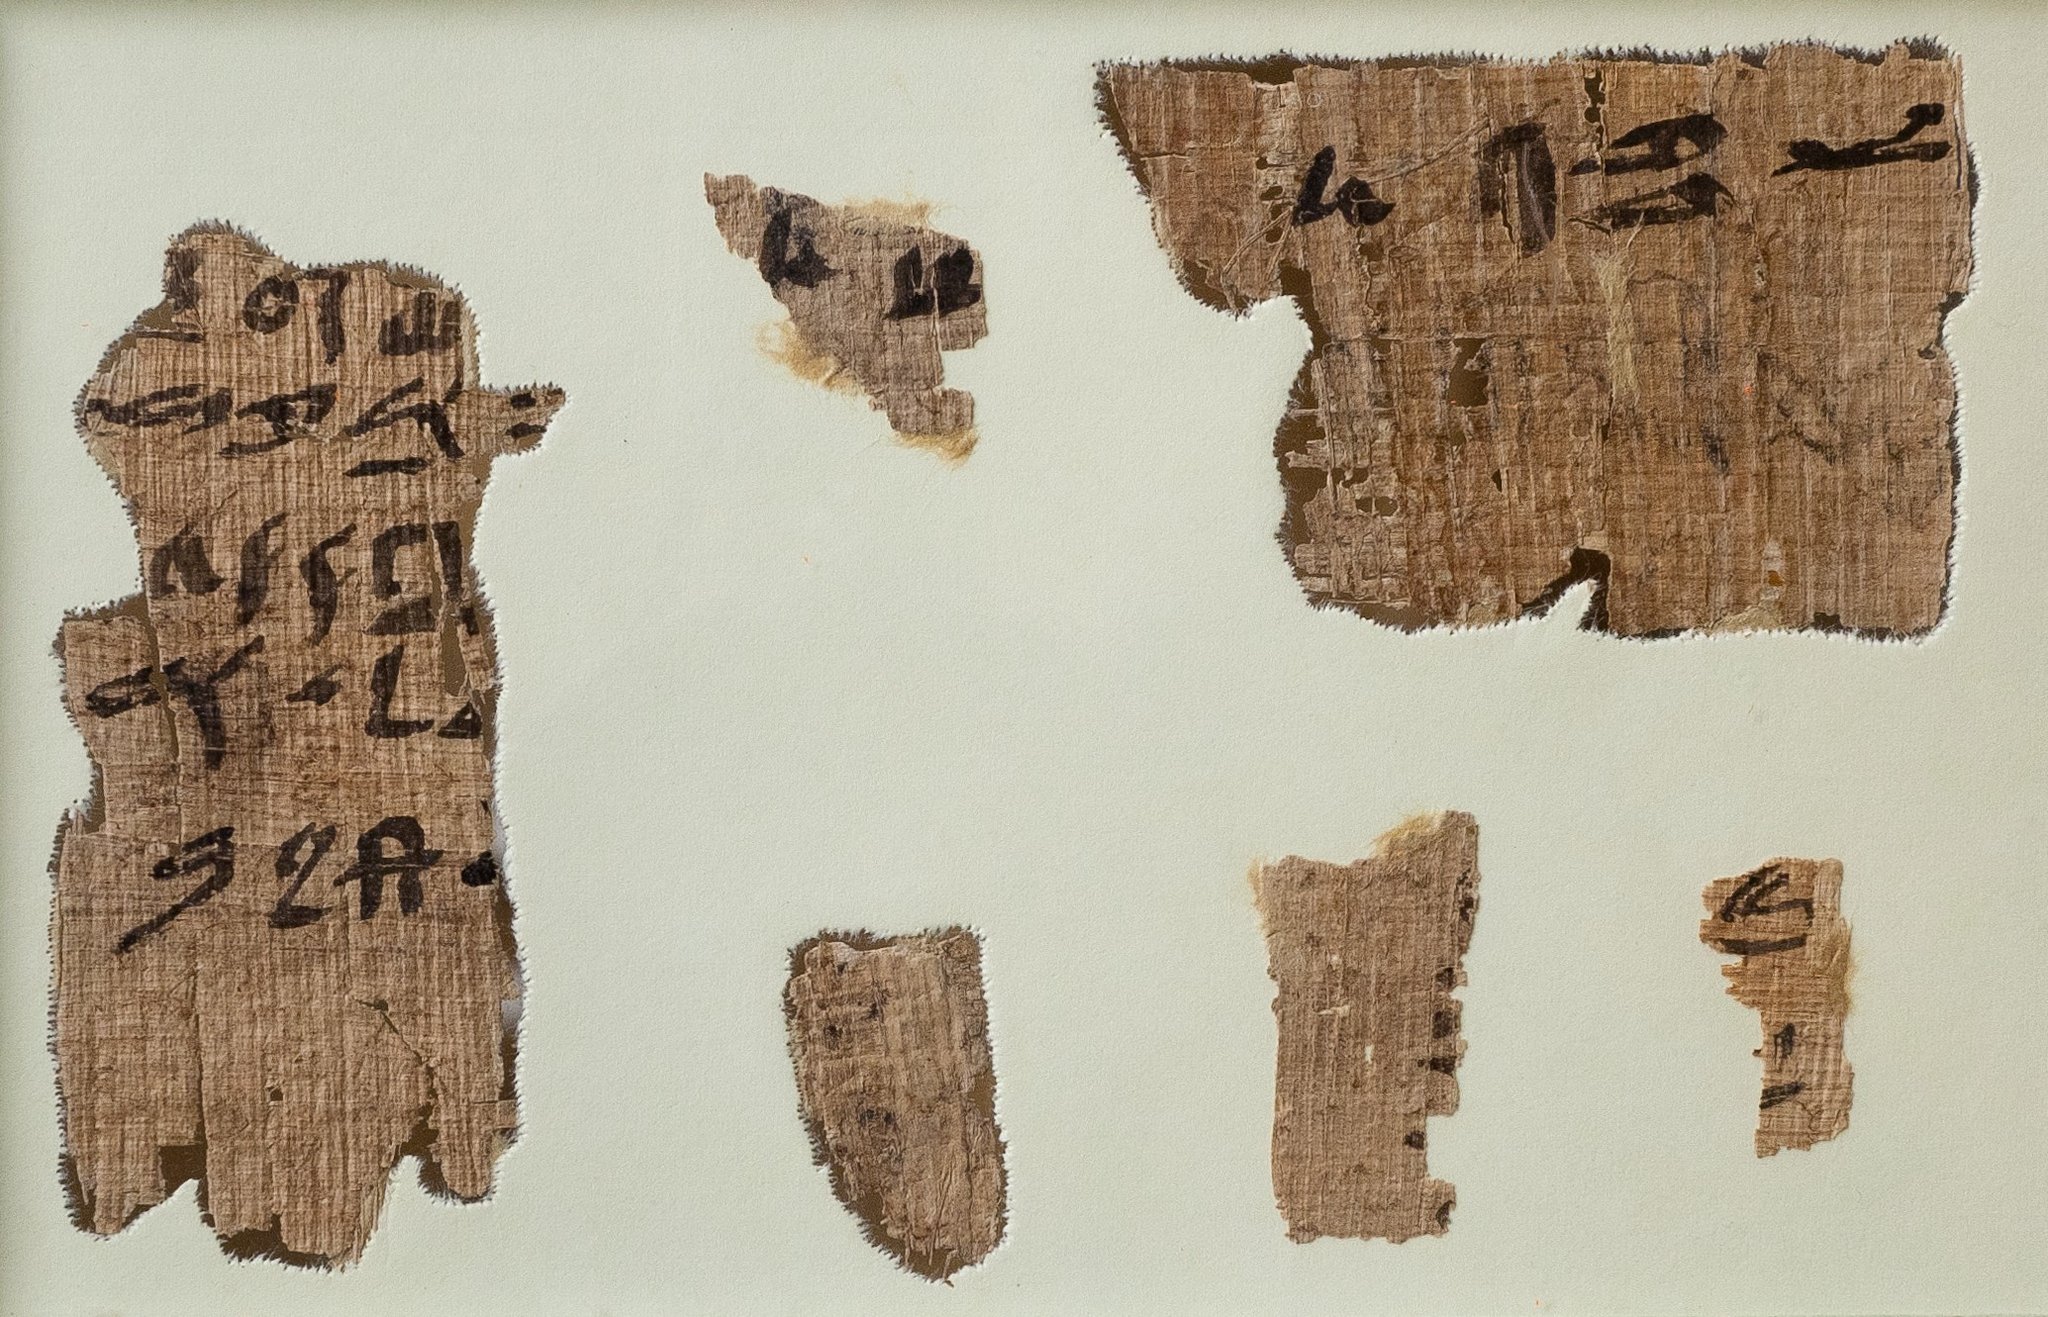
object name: papyrus, letter, heqanakht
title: Heqanakht Papyrus Fragments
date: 1961-1917 BCE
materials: ink, papyrus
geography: egypt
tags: documents,hieratic